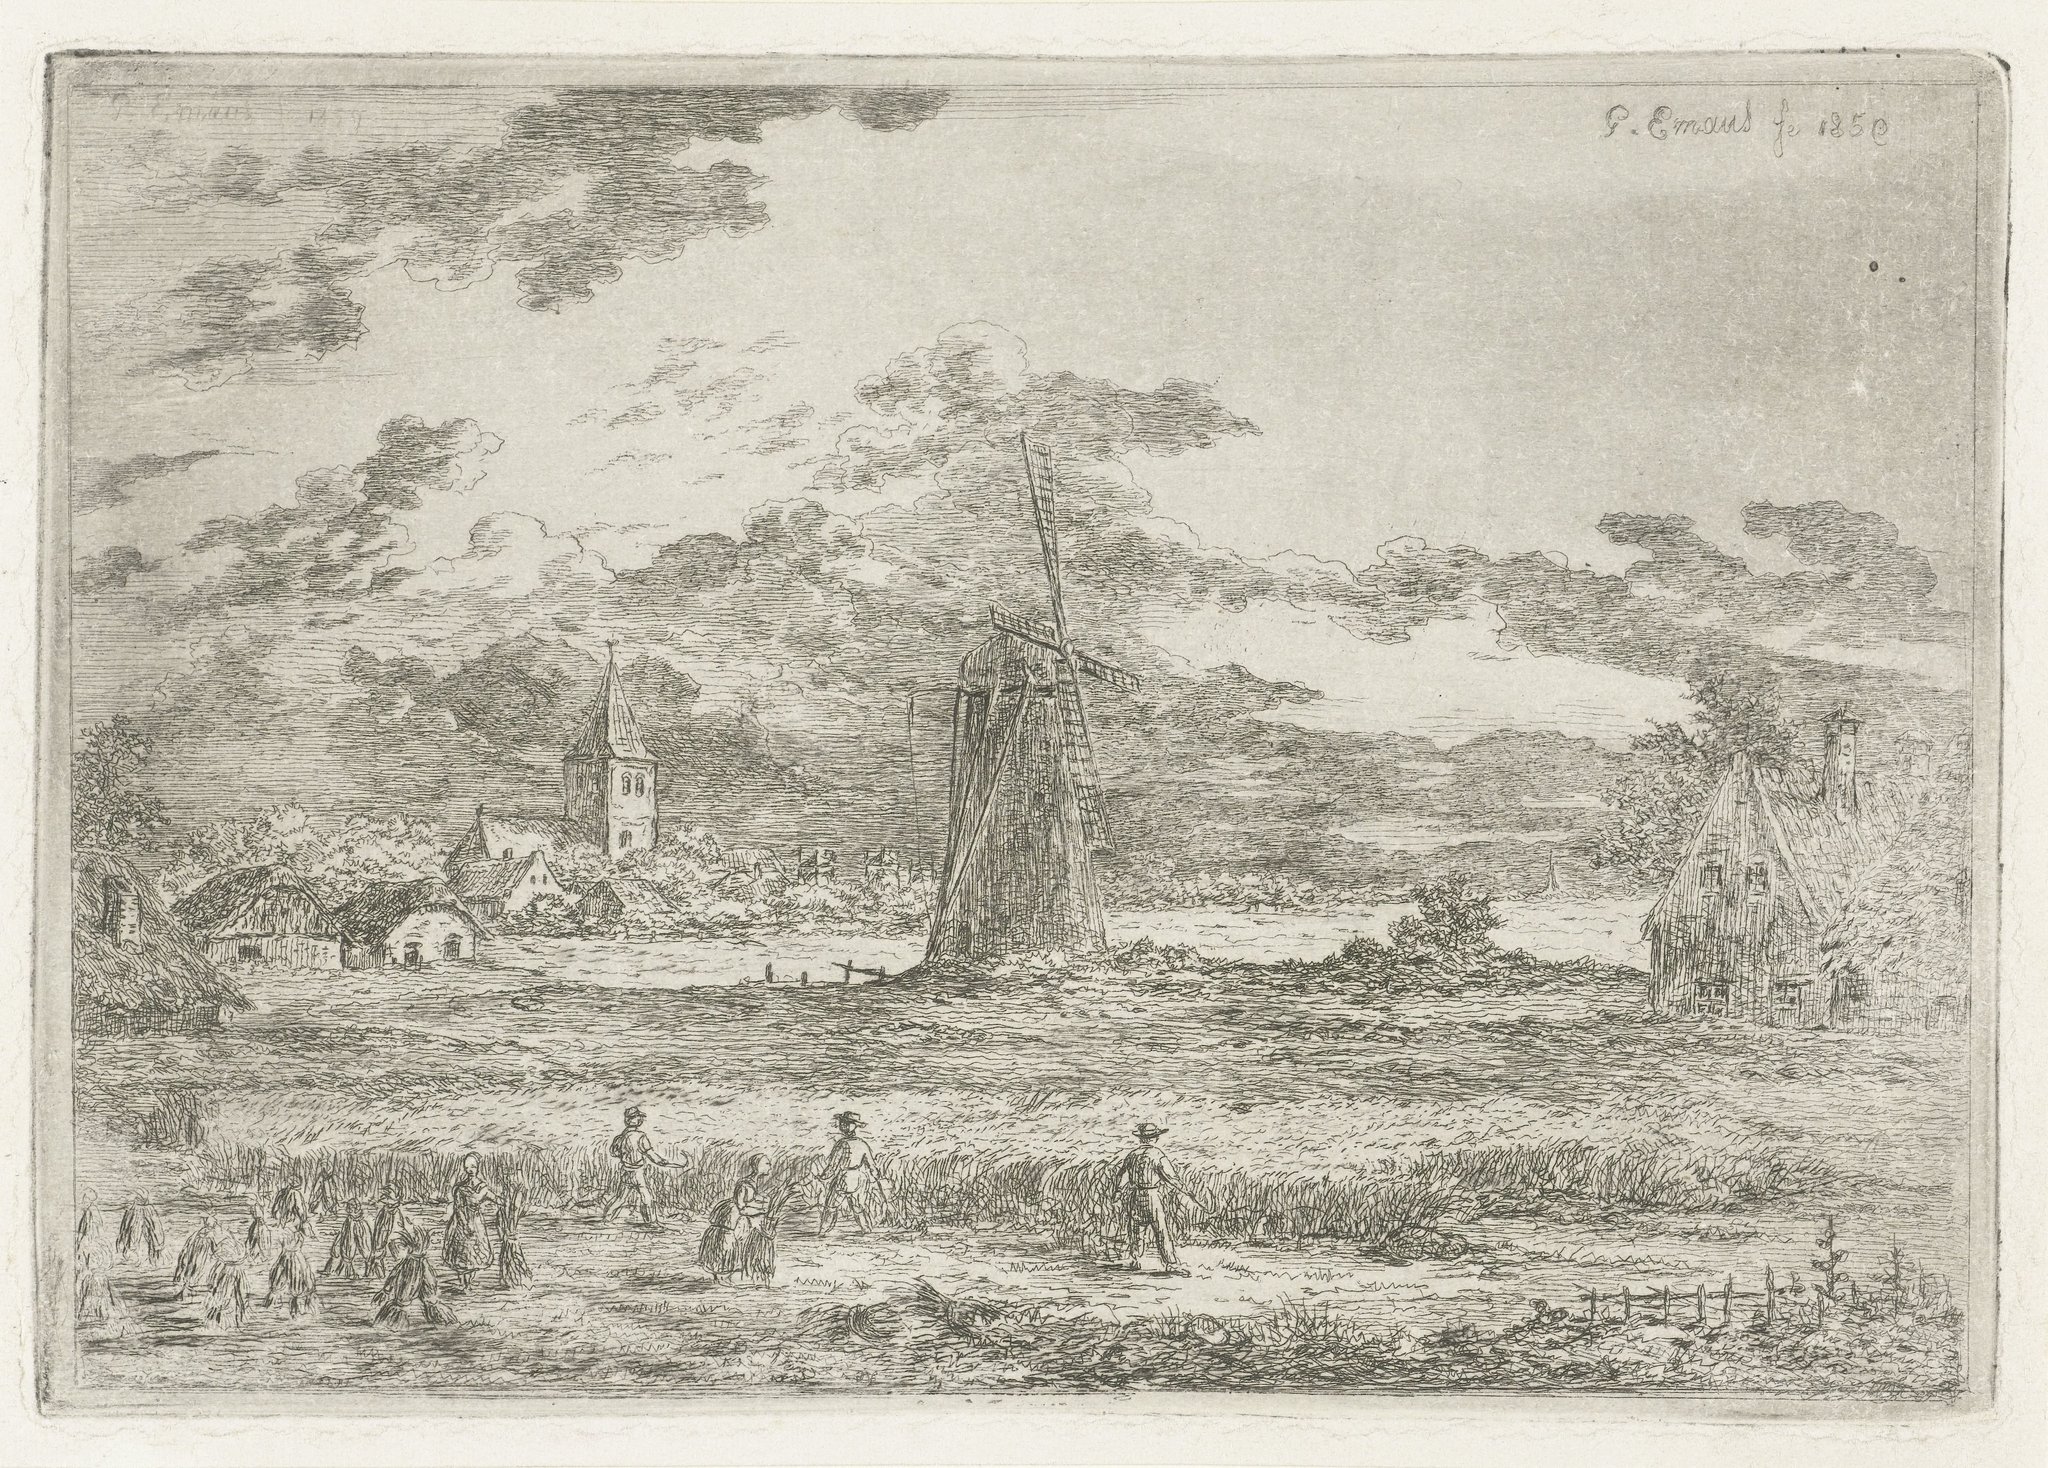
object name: print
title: Korenveld met molen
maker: gerardus emaus de micault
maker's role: draughtsman, print maker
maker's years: 1798-1863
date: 1859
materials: paper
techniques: etching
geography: netherlands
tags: harvest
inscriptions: collector's mark: Lugt 2228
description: Op een akker zijn drie mannen koren aan het maaien, waarna twee vrouwen de halmen in schoven bijeen binden. Op de achtergrond een molen en een dorp.